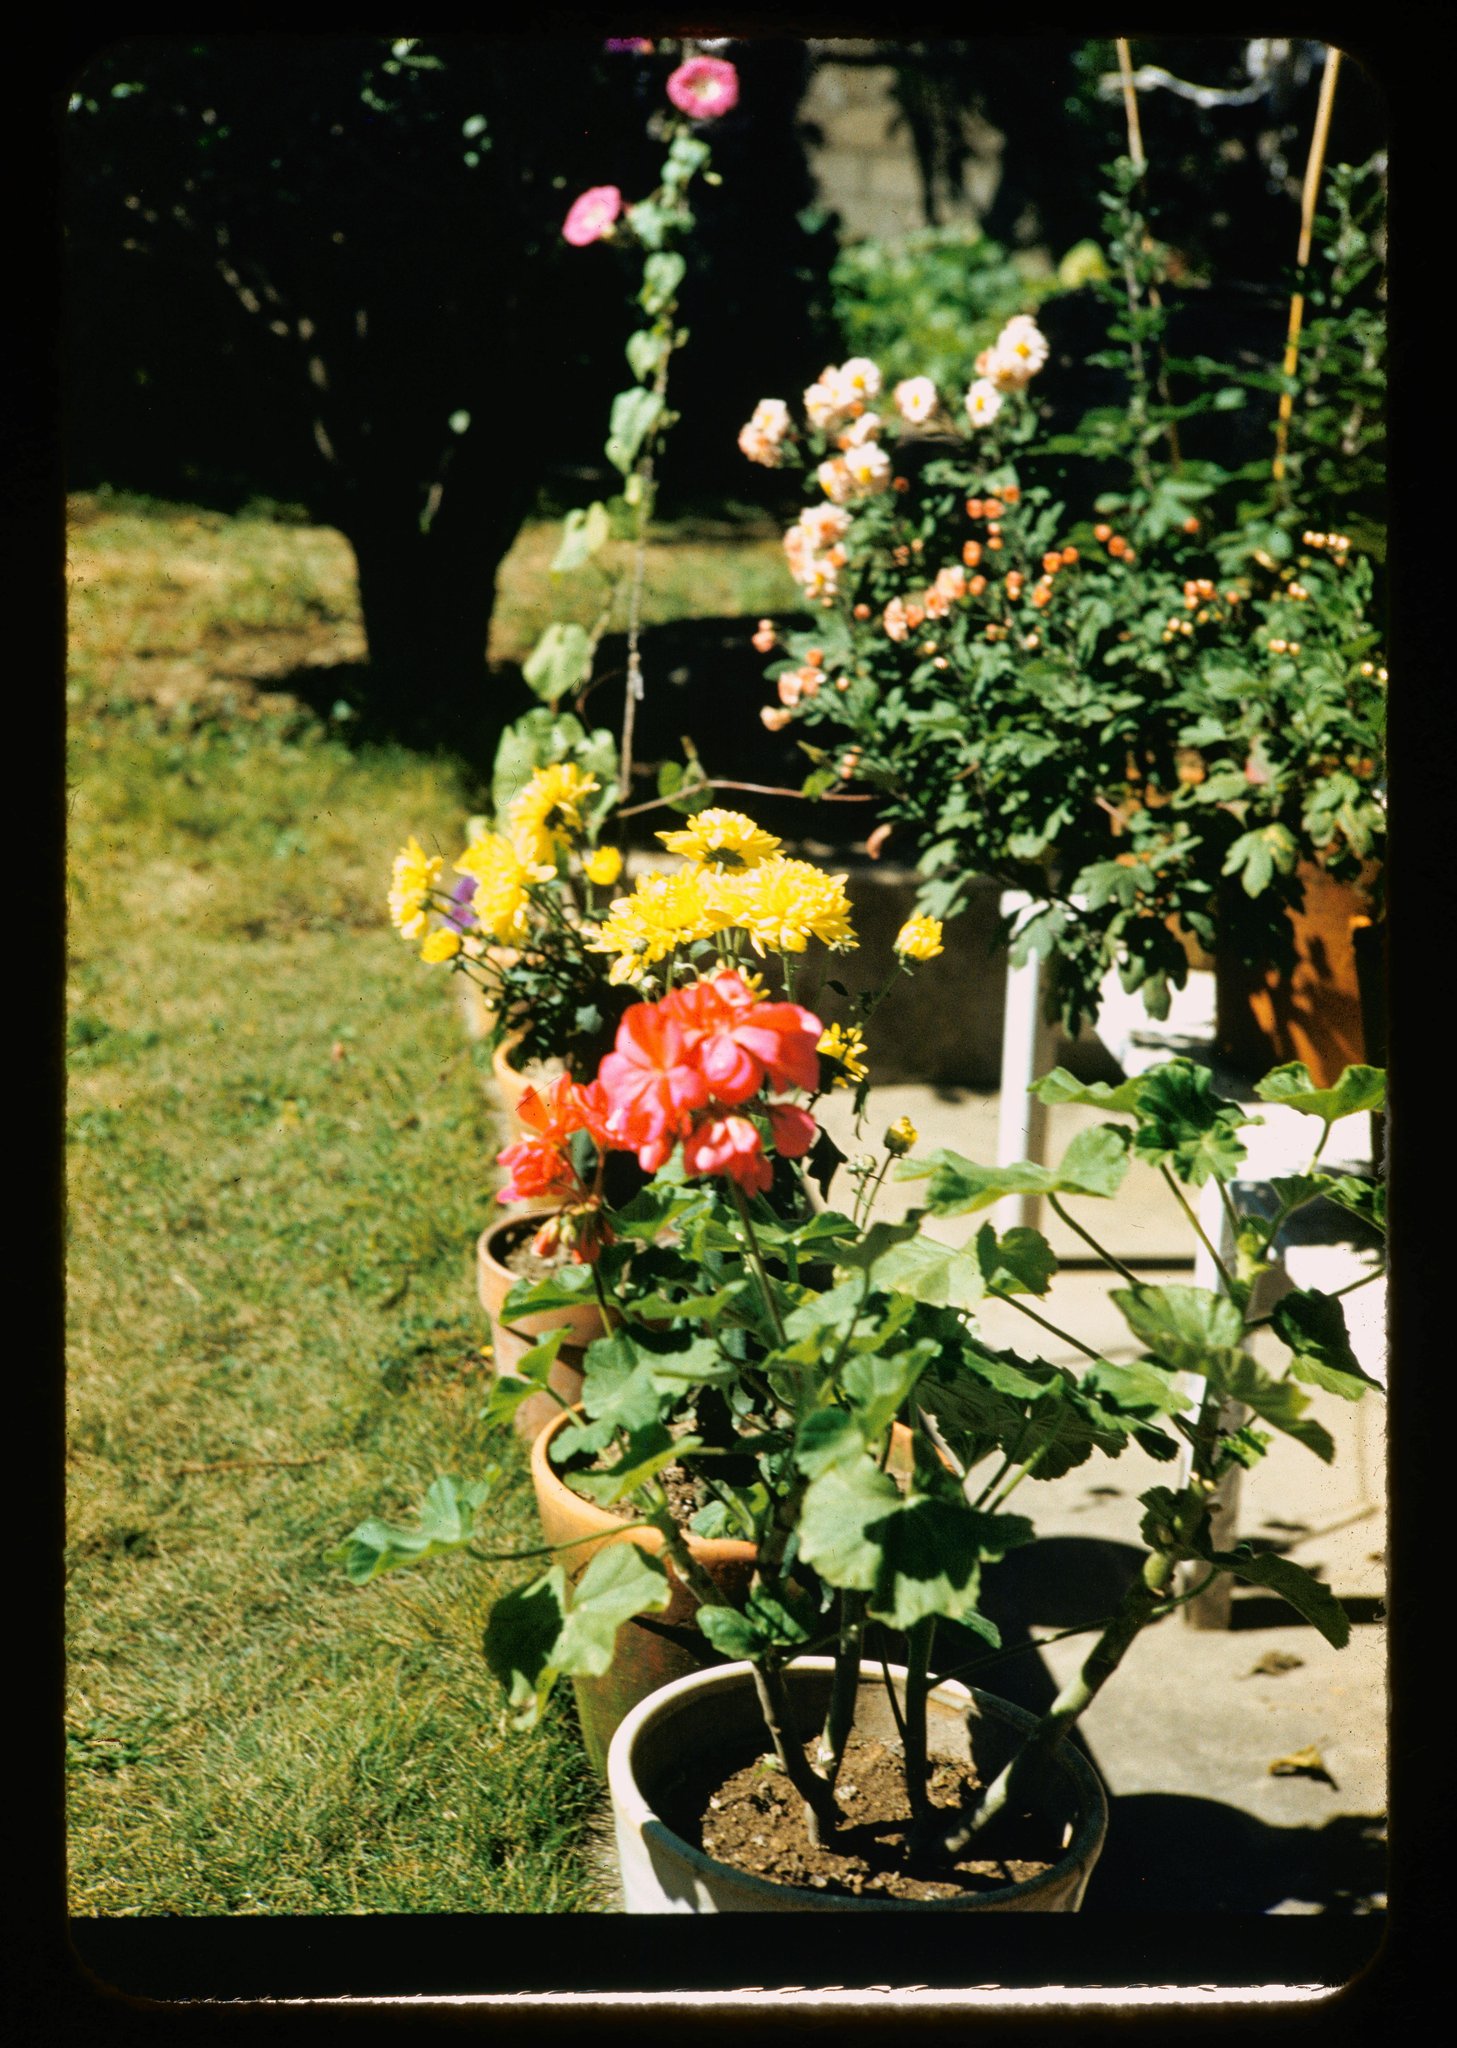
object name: color slide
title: De tuin van de heer van Marlen, Busan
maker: david ketel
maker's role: diplomaat, sinoloog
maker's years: 1913-2008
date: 1952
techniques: slide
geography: korea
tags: united nations